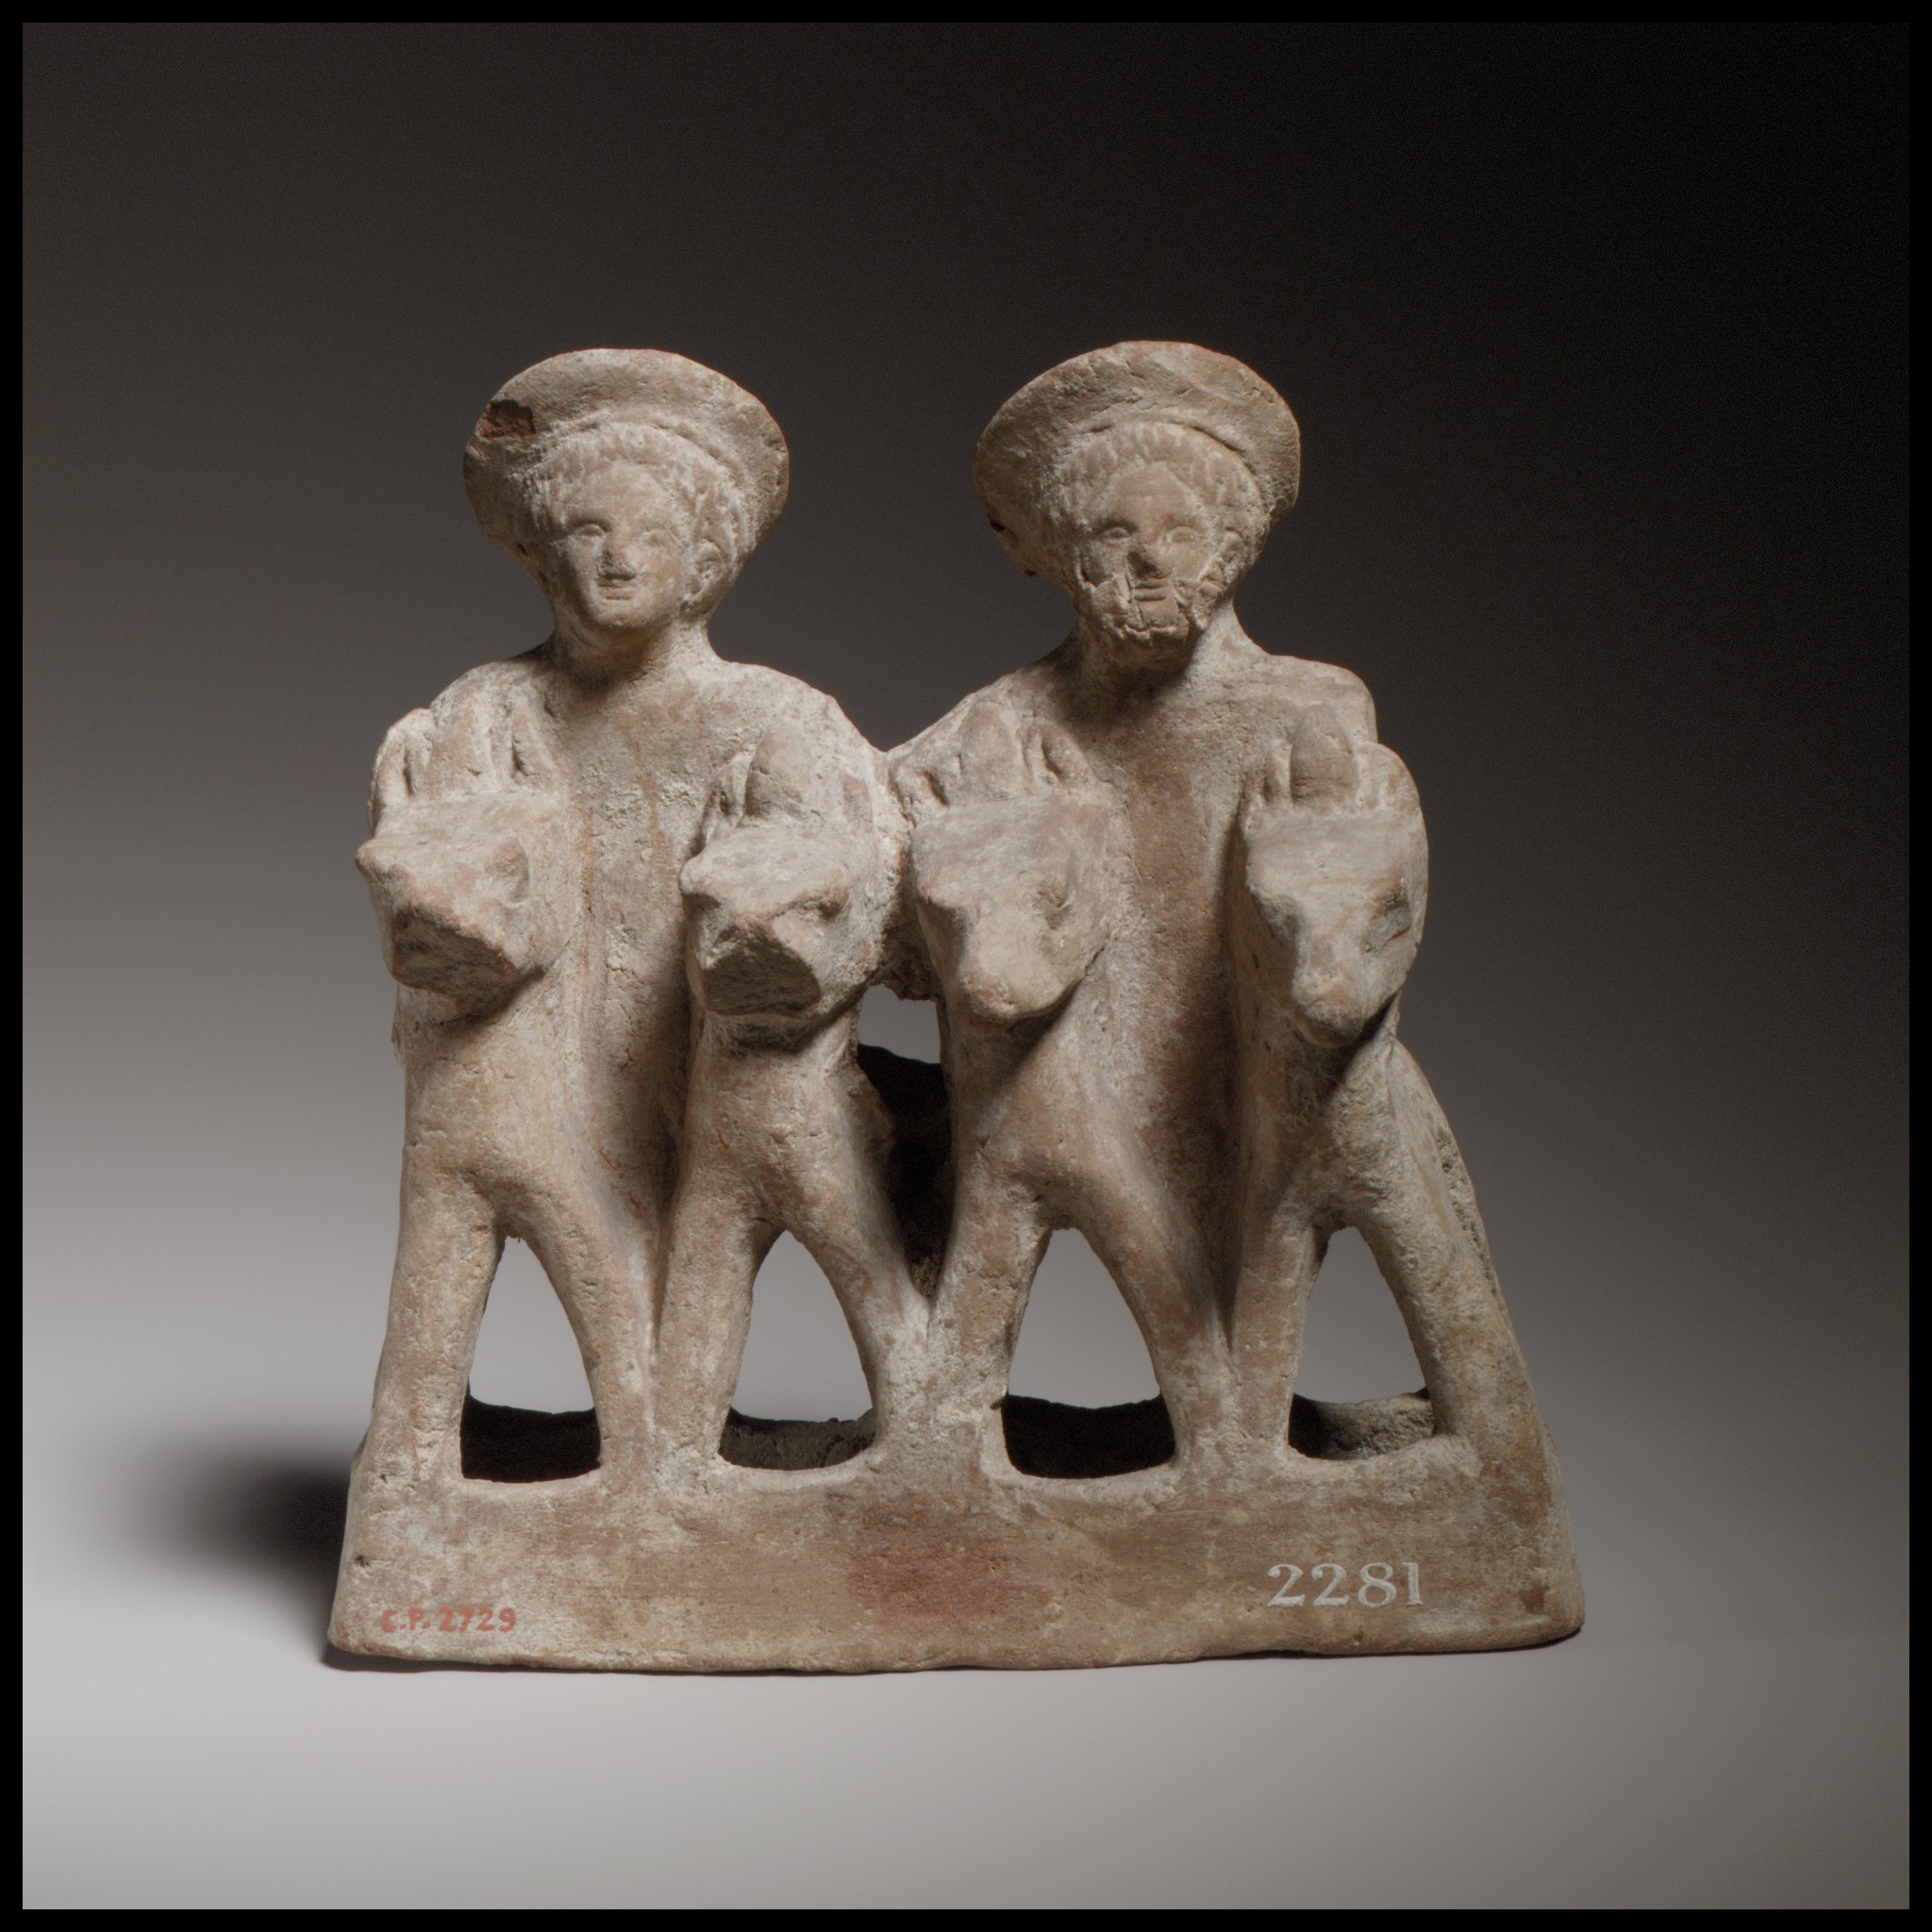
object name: model of a chariot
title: Chariot group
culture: cypriot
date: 400-301 BCE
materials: terracotta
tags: men,horses